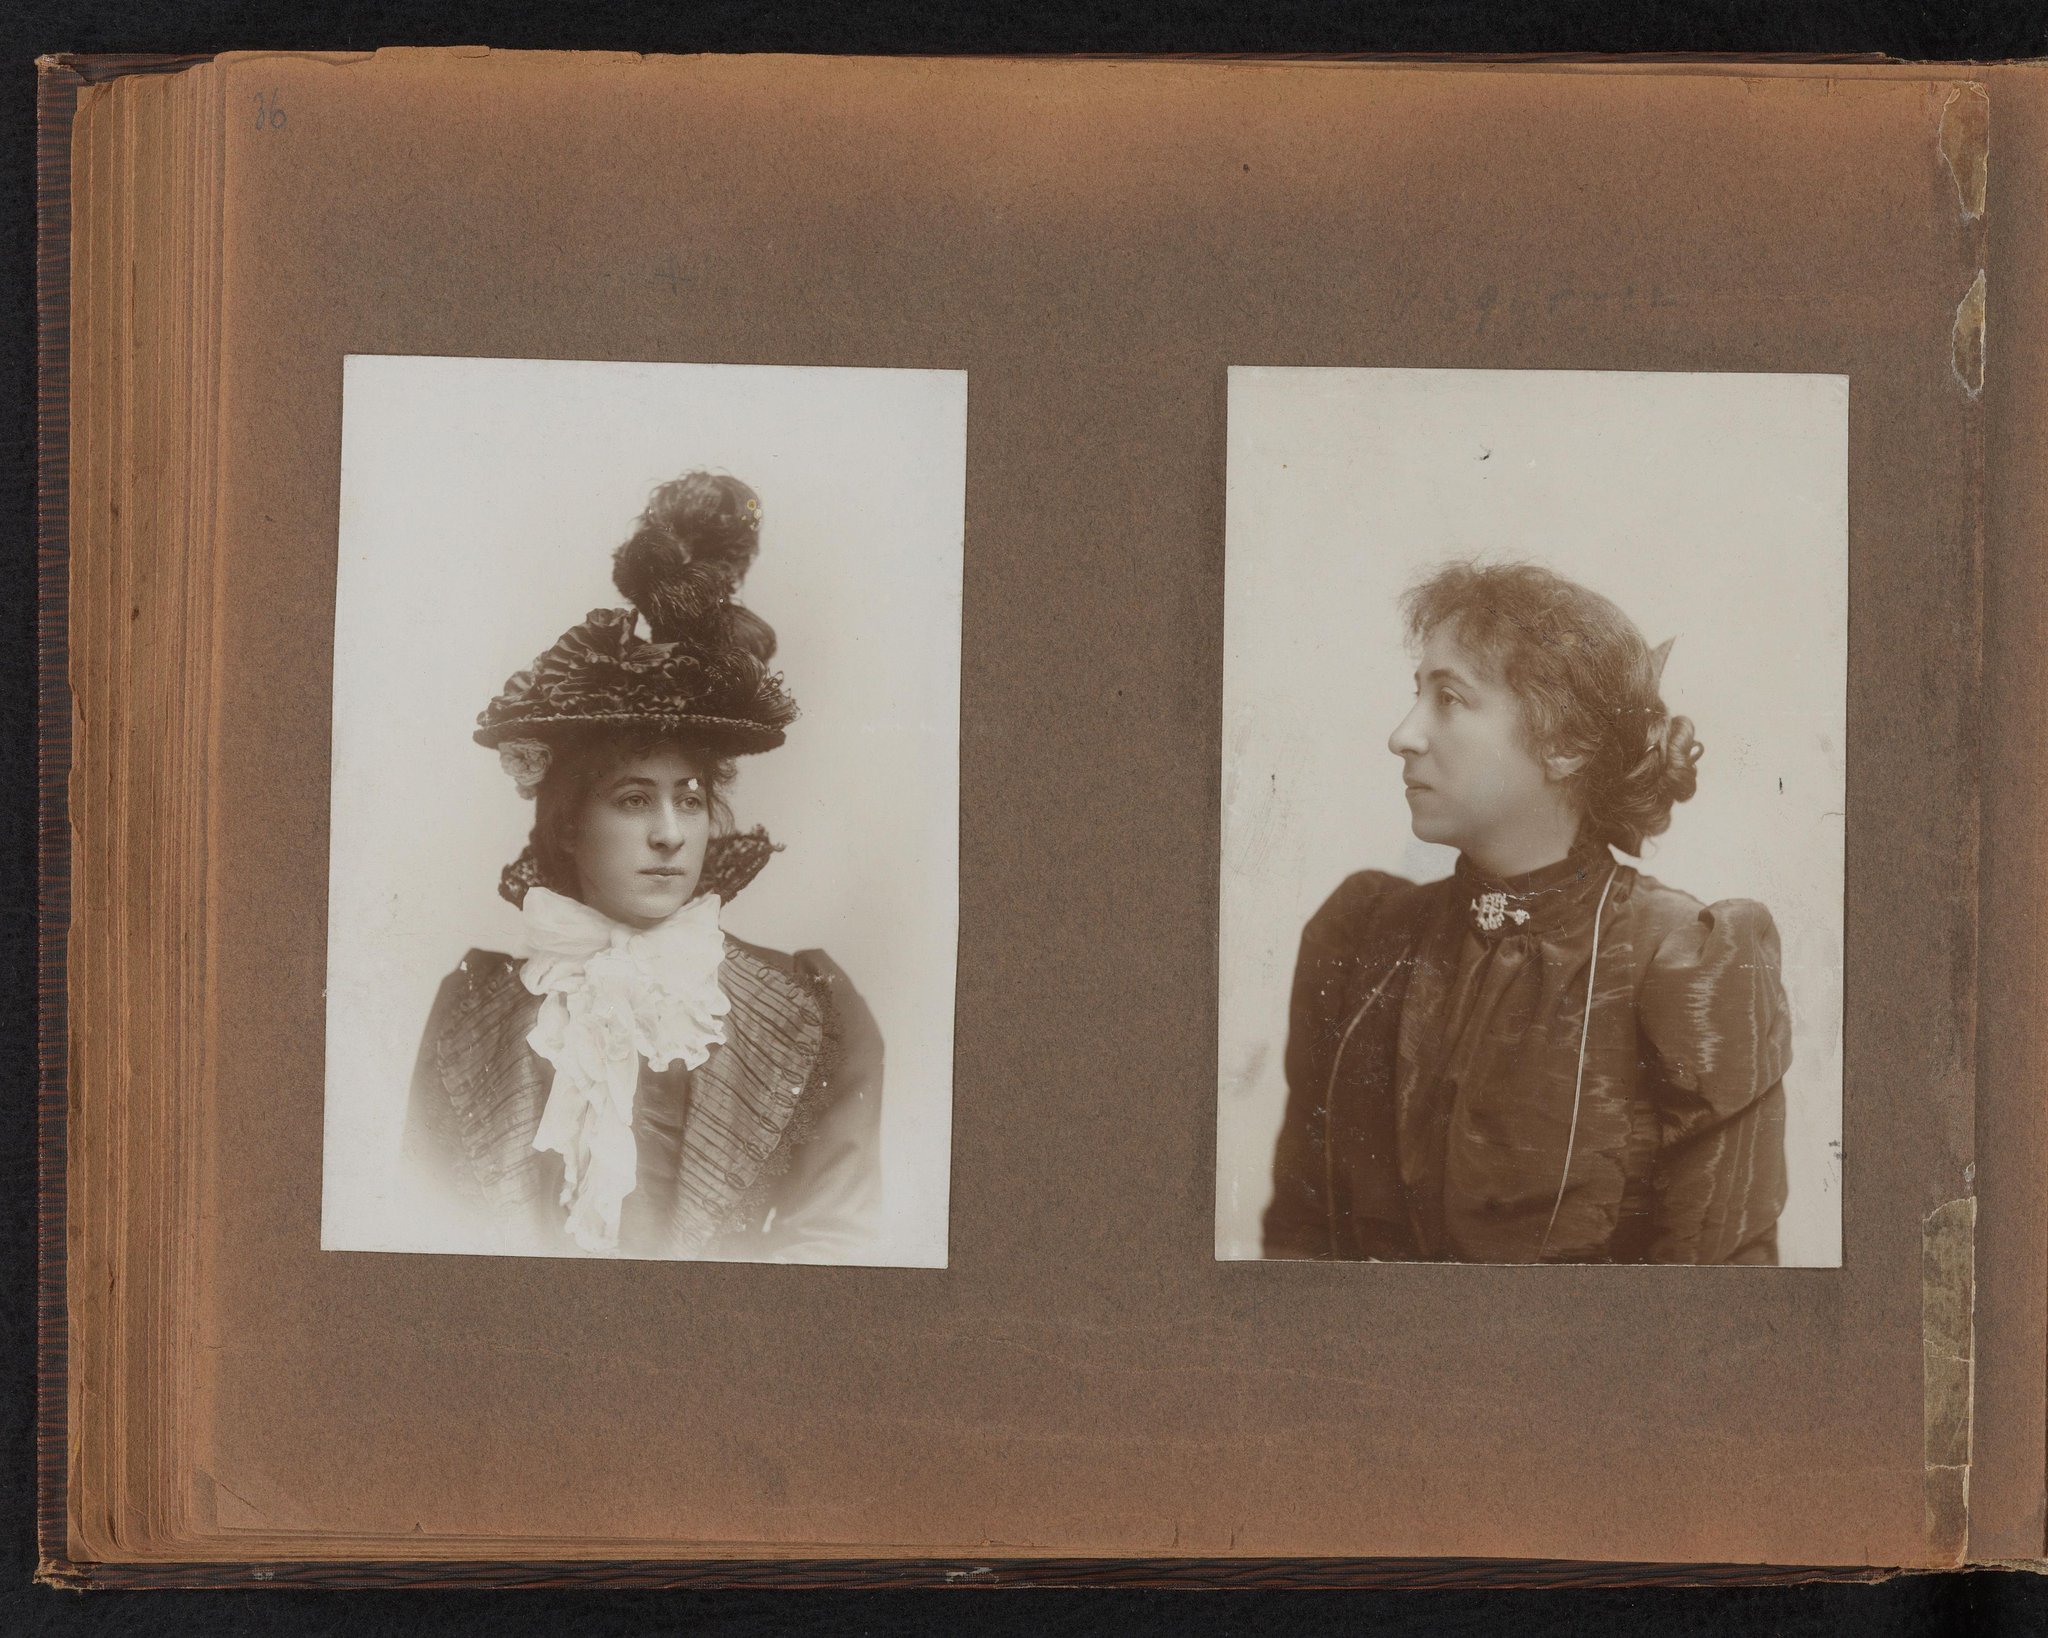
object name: album leaf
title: Bladzijde uit het fotoalbum van de familie Diepenbrock met 2 foto's van Alphons Diepenbrock en zijn omgeving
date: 1895-1925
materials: cardboard, photographic support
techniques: collodion silver print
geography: amsterdam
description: Bruin albumblad 36 van familiealbum van Alphons Diepenbrock. Bladzijde uit het fotoalbum van de familie Diepenbrock met twee portretten van Cécile.